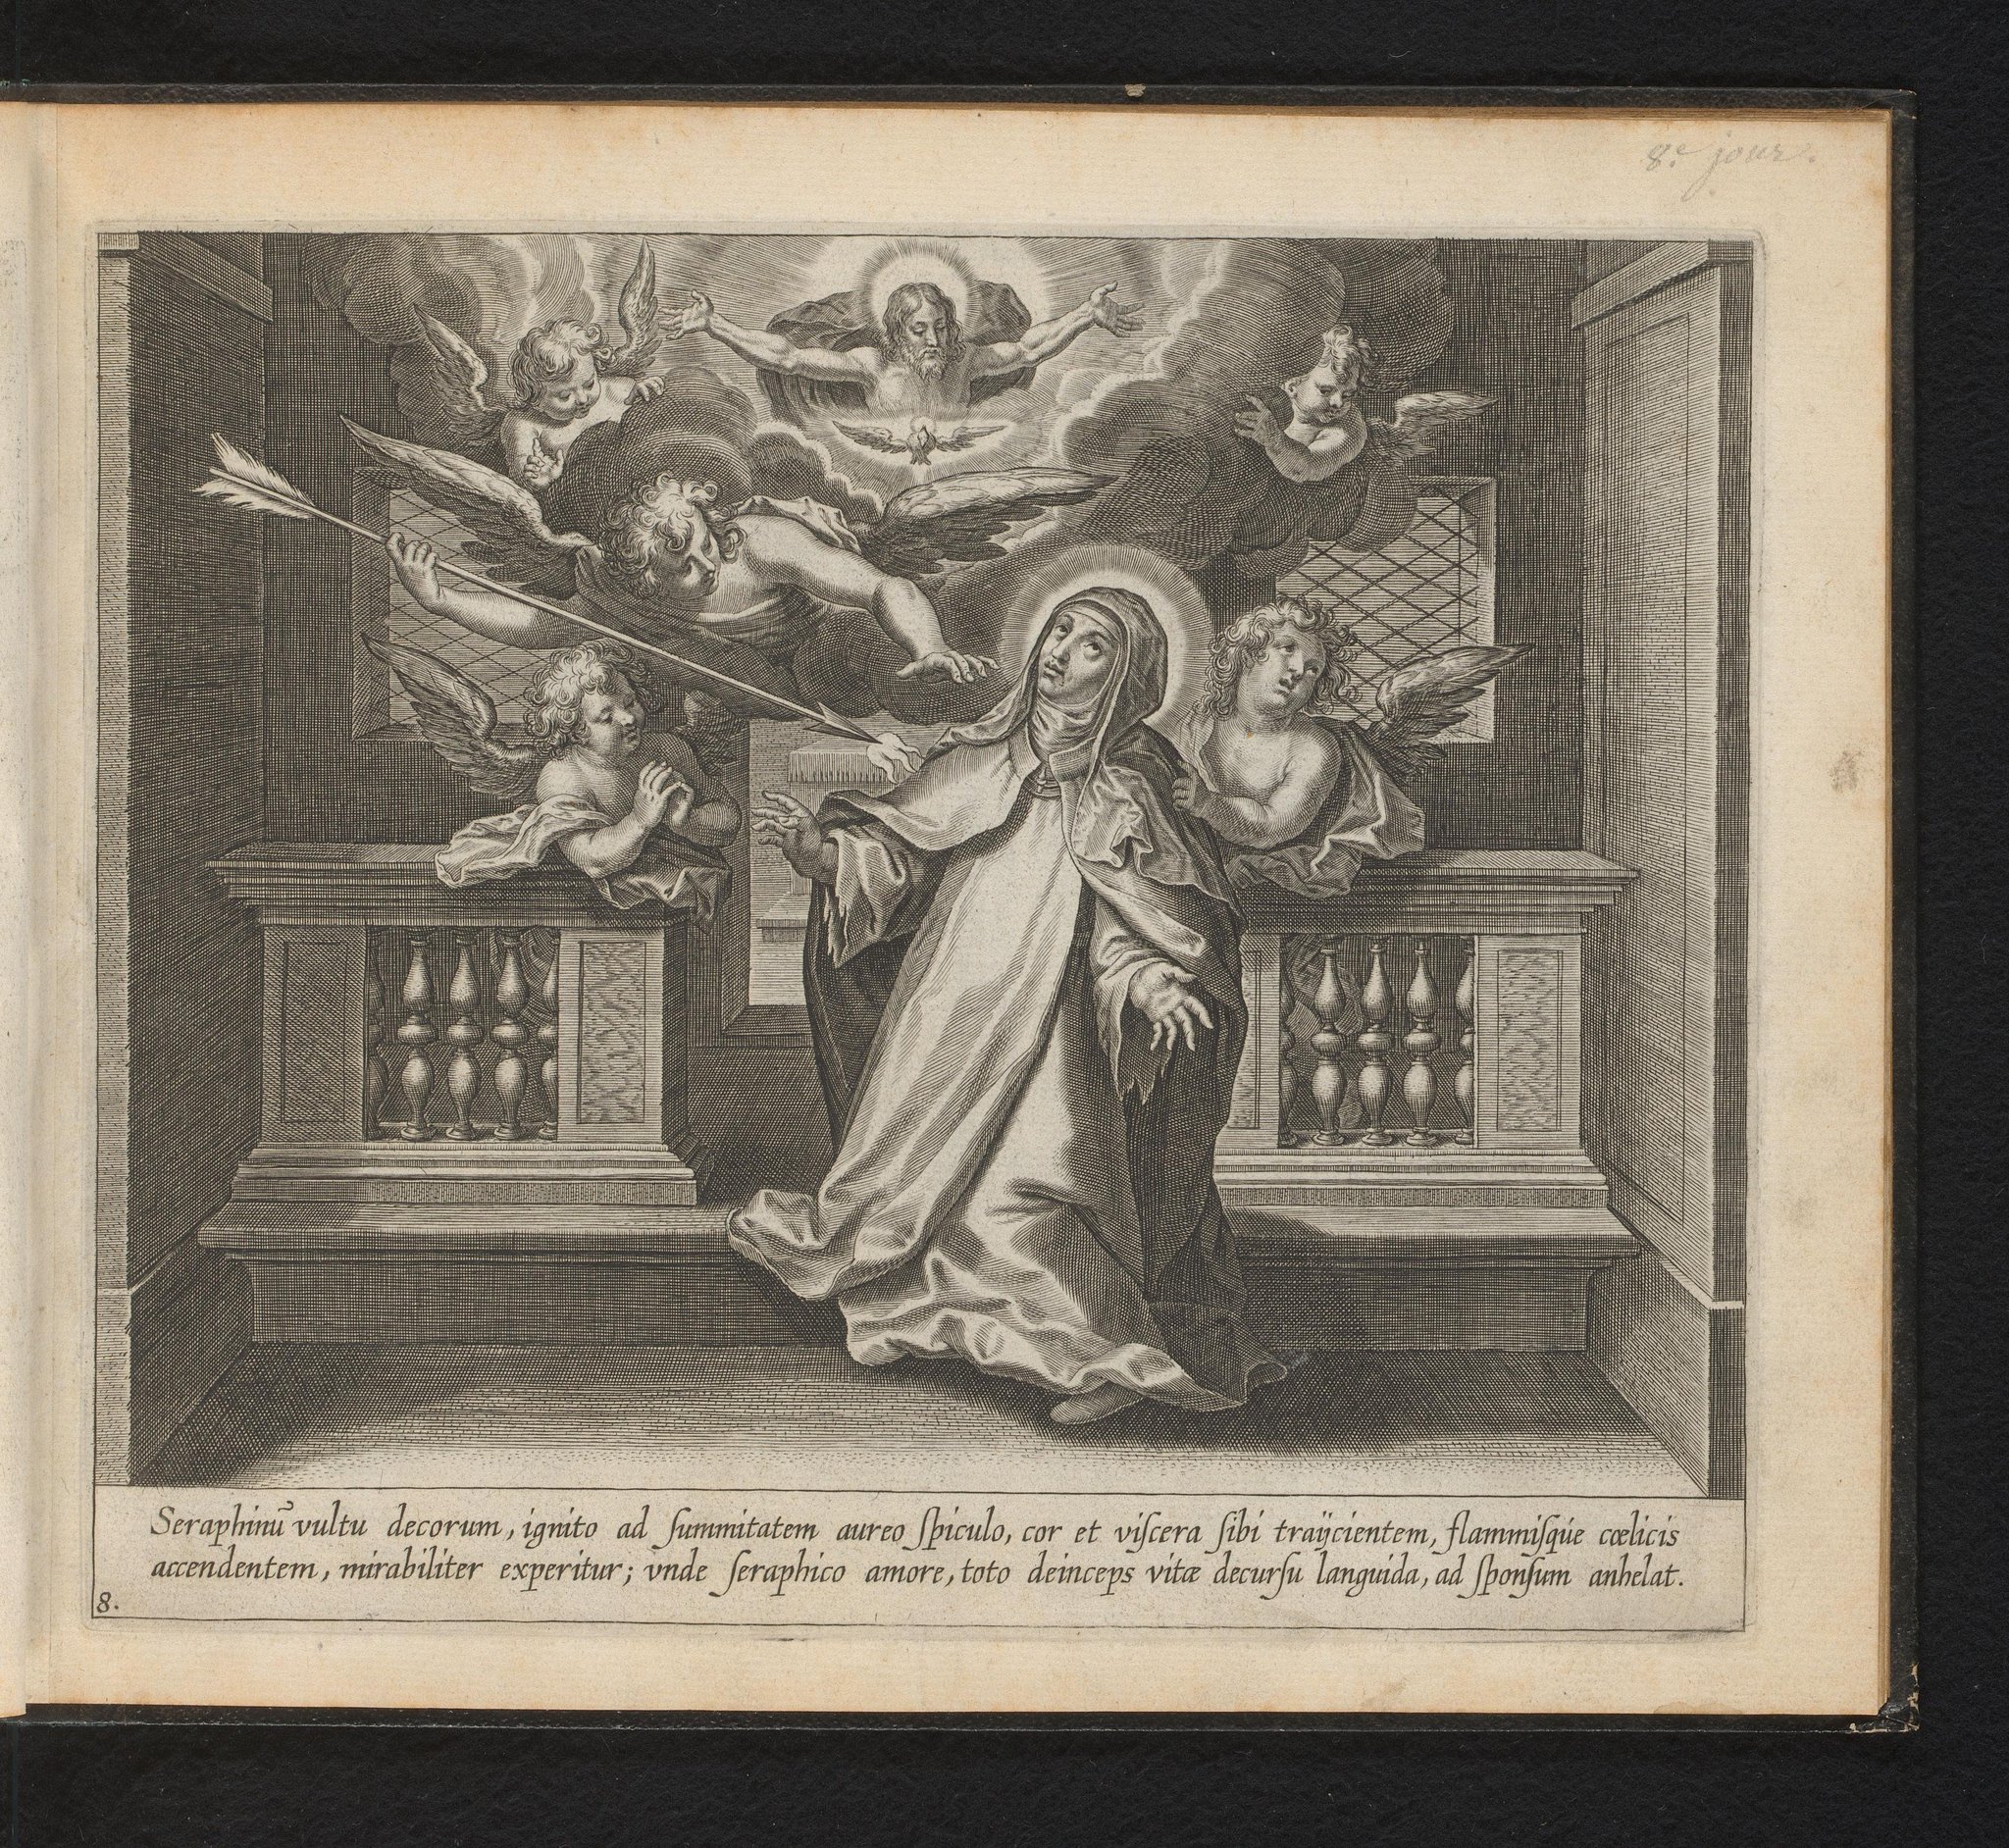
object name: print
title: Een serafijn verschijnt aan Theresa en vult haar hart met liefde voor God d.m.v. een pijl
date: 1613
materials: paper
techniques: engraving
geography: flanders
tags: an angel pierces the heart of the (swooning) st. theresa with a spear or dart with a flaming tip ('transverberatio')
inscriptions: number: ‘8’, caption: ‘Seraphinu vultu decorum...ad sponsum anhelat.’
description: Prent in album 'Vita B. Virginis Teresiae A. Jesu ordinis carmelitarum excalceatorum piae restauratricis..., 1613.